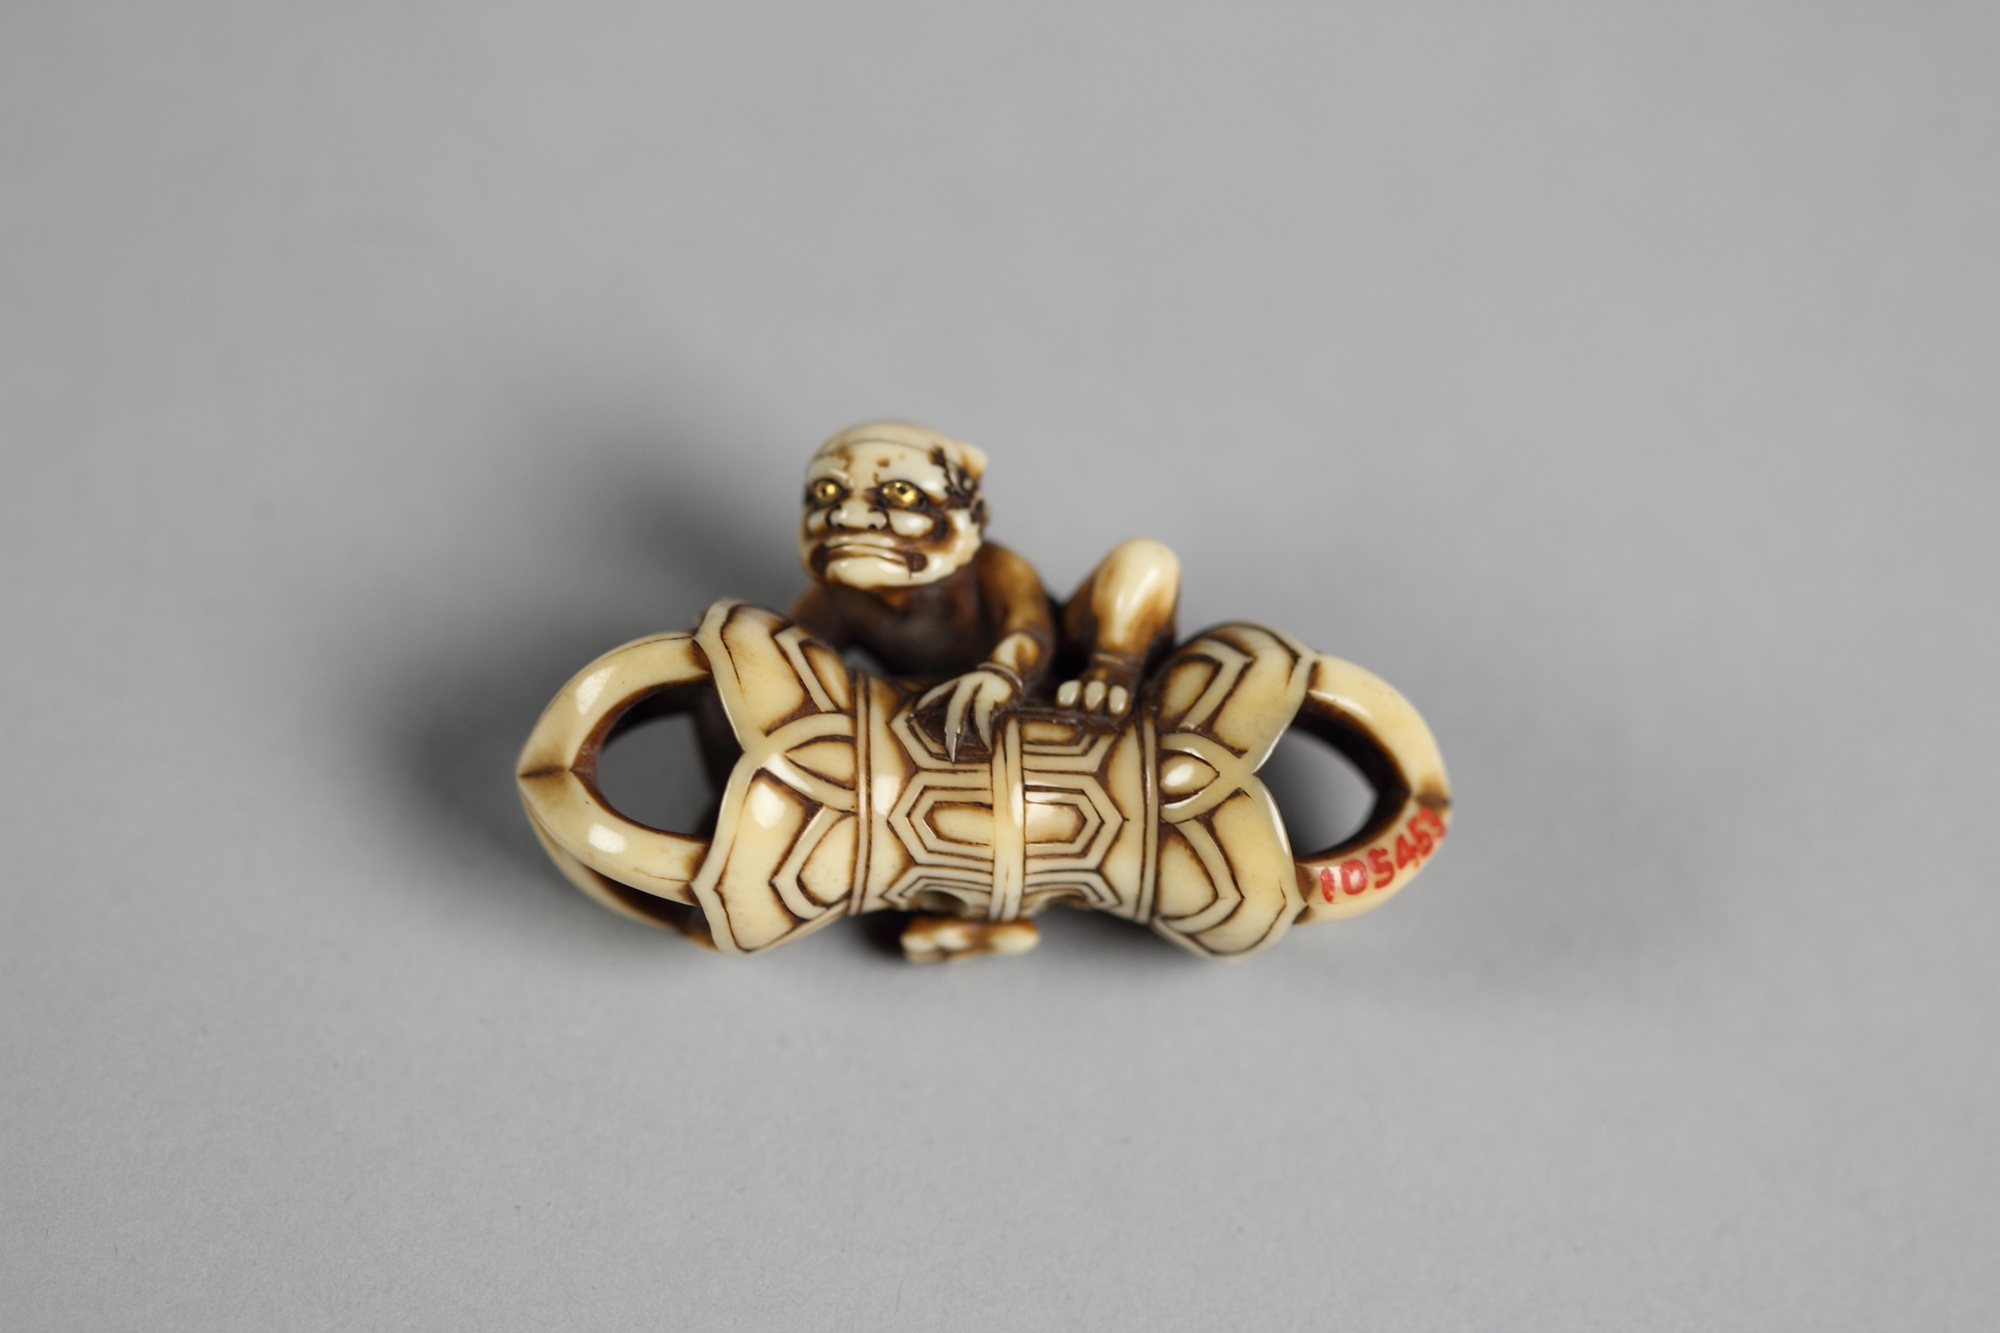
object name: netsuke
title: Netsuke of Demon with Gold Eyes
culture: japanese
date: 1801-1900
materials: ivory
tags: demons